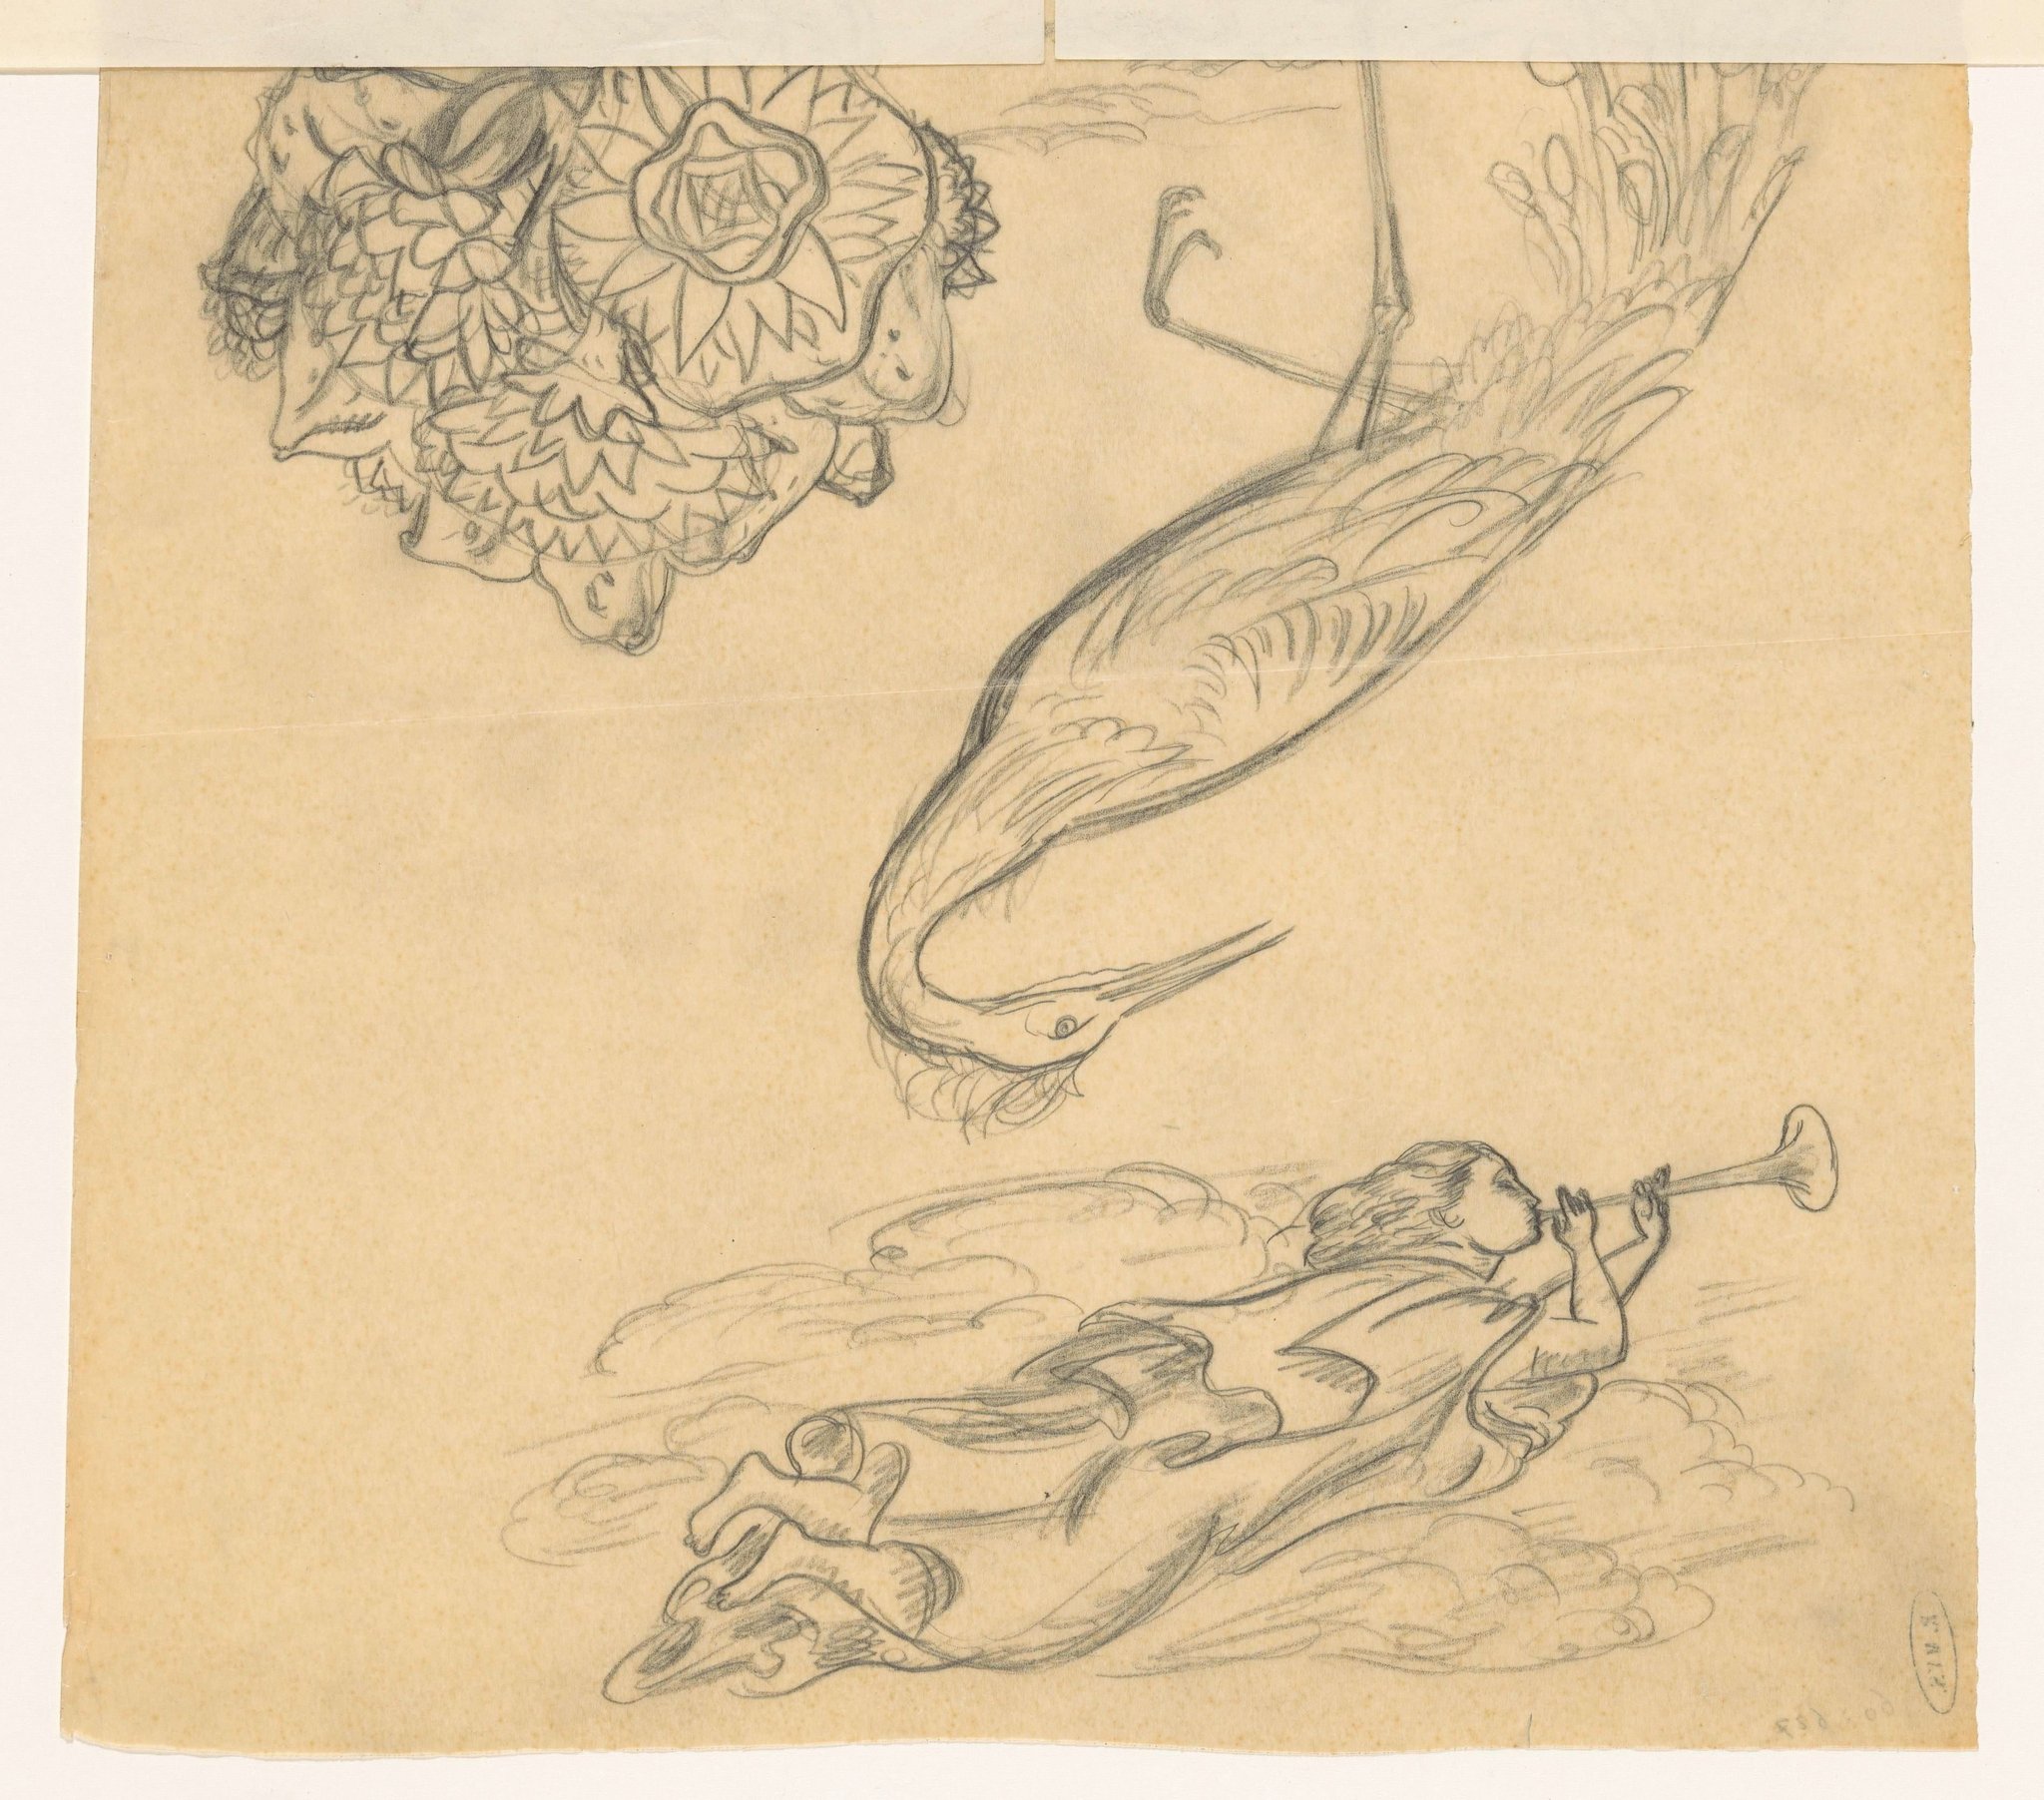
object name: drawing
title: Schetsblad met zwevende vrouw met trompet, een reiger en een mand met bloemen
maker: leo gestel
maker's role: draughtsman, print maker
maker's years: 1881-1941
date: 1891-1941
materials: pencil, paper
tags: cut flowers; nosegay, bunch of flowers, shore-birds and wading-birds: heron, horn, trumpet, cornet, trombone, tuba, container made of plant material other than wood: basket, flying - aa - female human figure